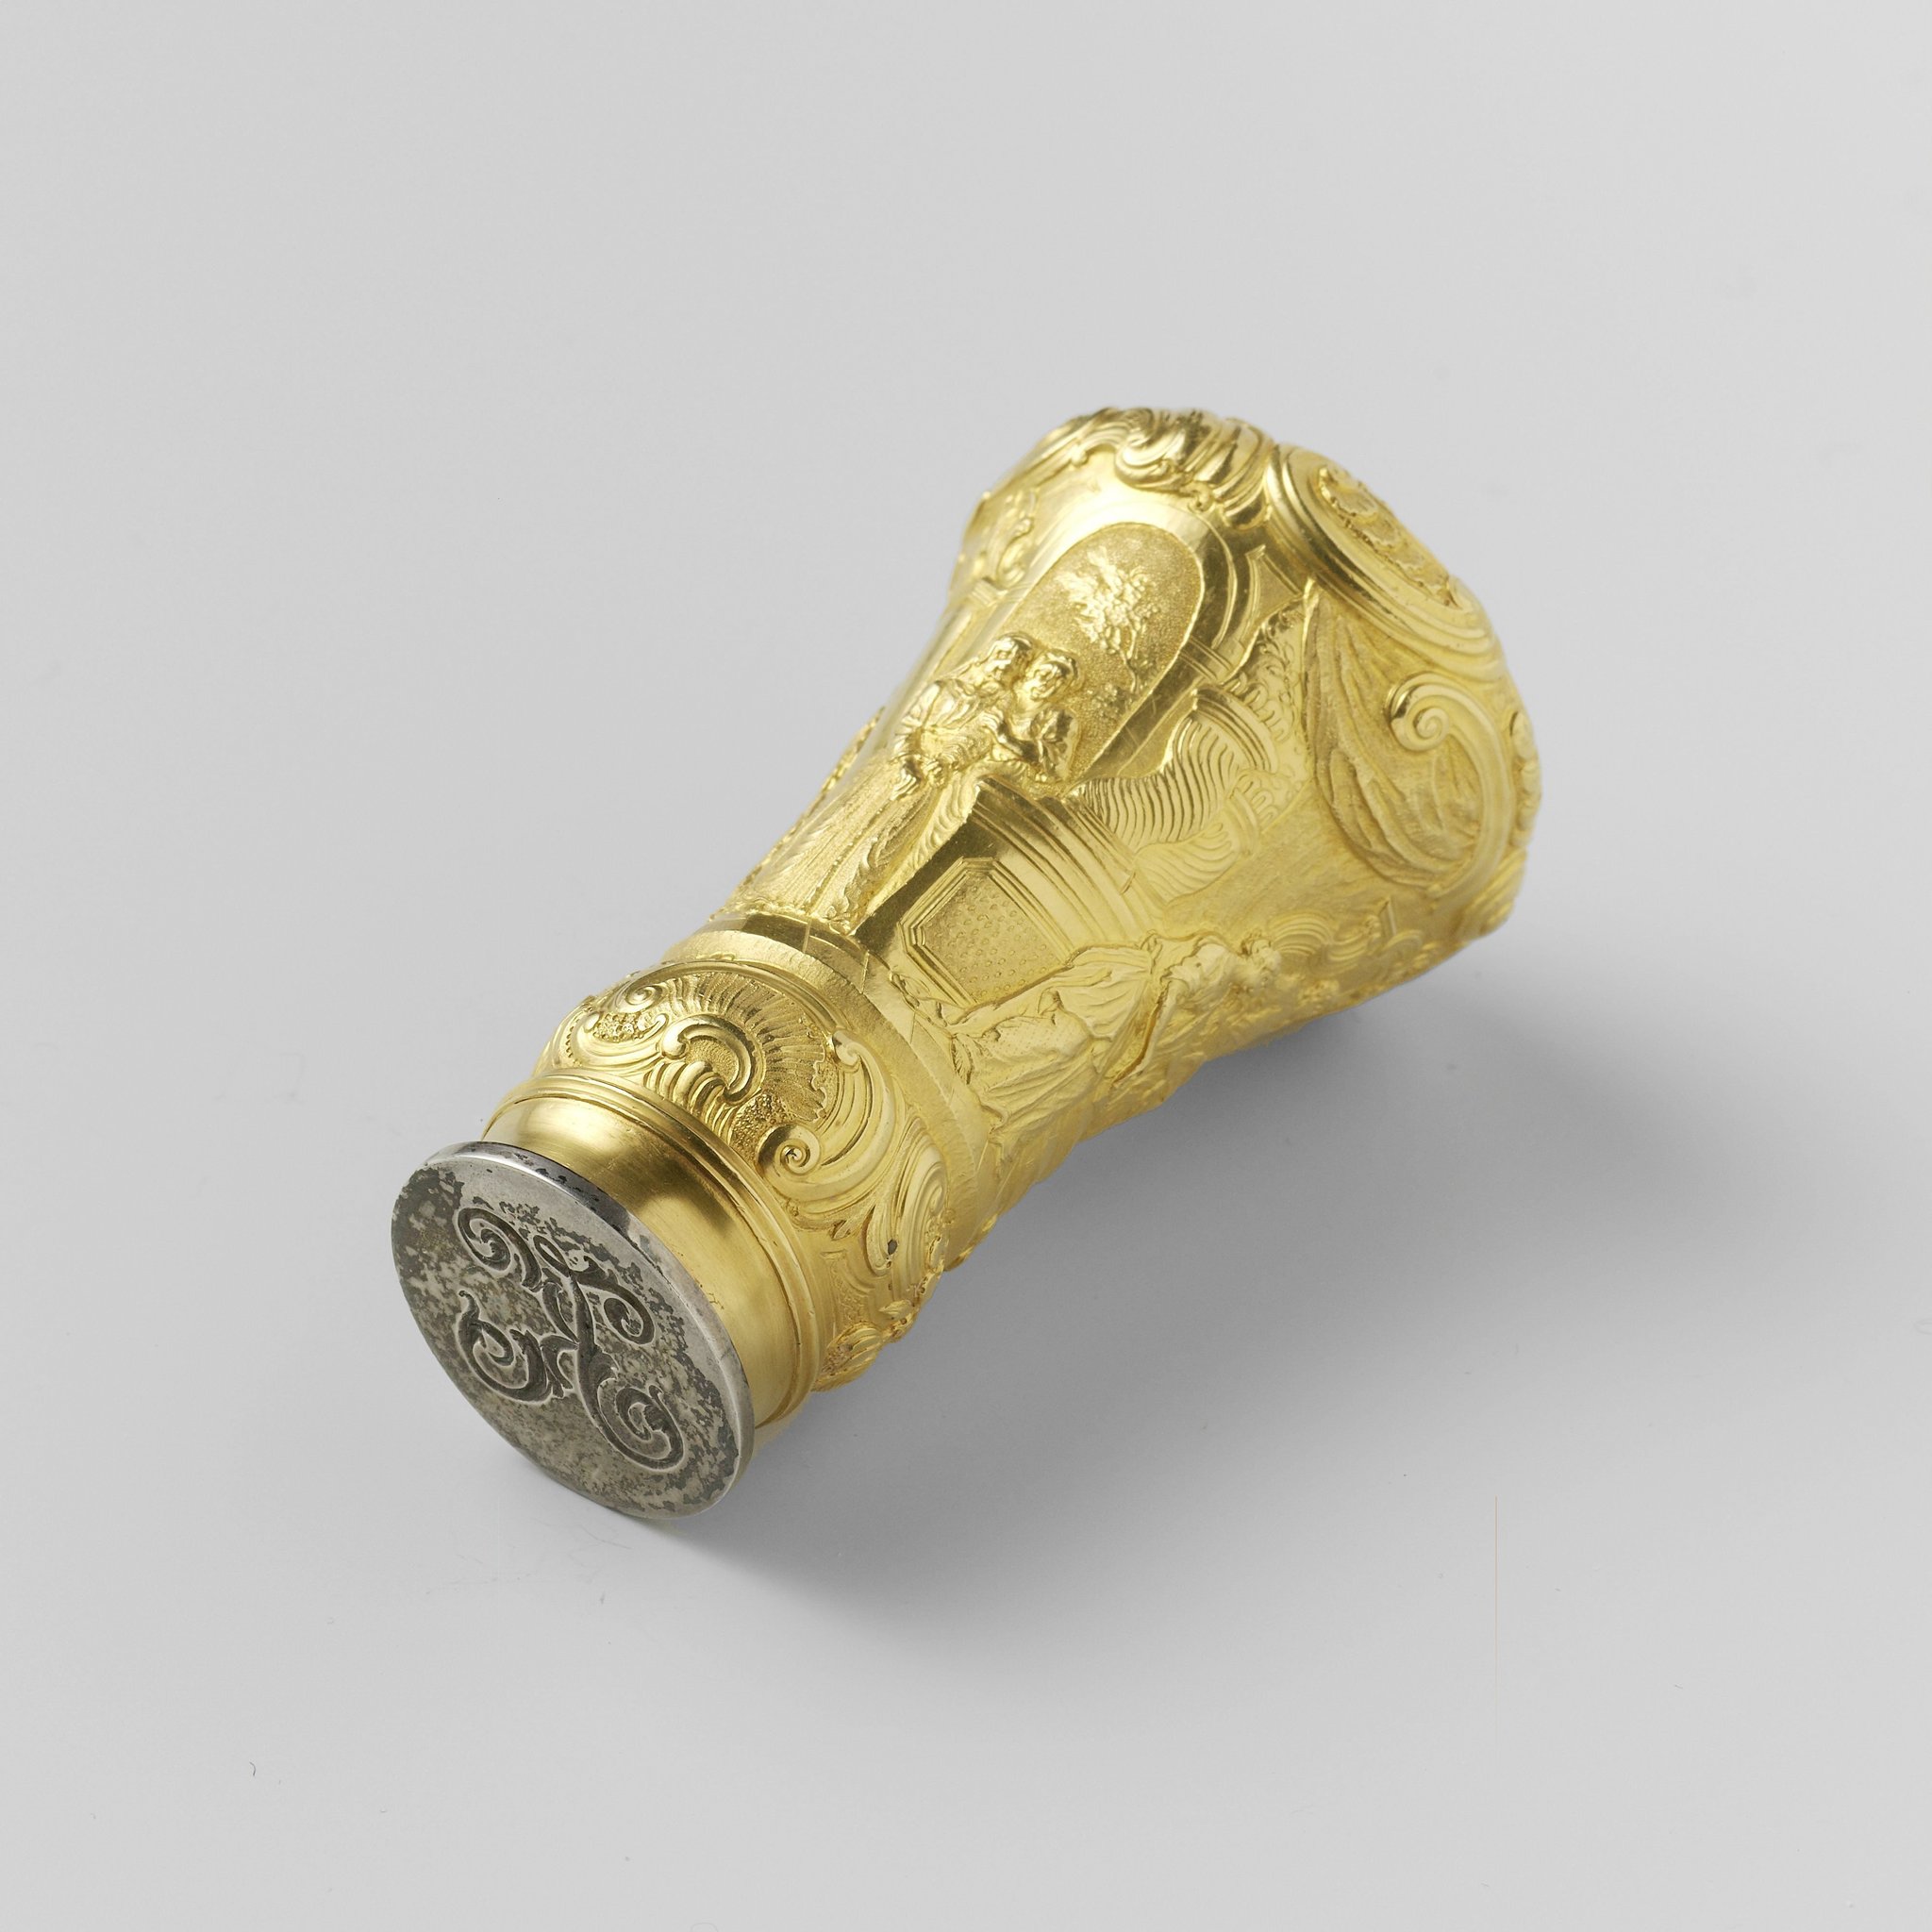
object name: wandelstokknop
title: Wandelstokknop, toegepast als cachet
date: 1751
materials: gold, steel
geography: amsterdam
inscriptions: maker's mark, signature: ‘I: Naudin fecit’, date letter: ‘R’, town mark, alloy mark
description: Cane handle. Gold. Amsterdam, c. 1750, by Jean Naudin.